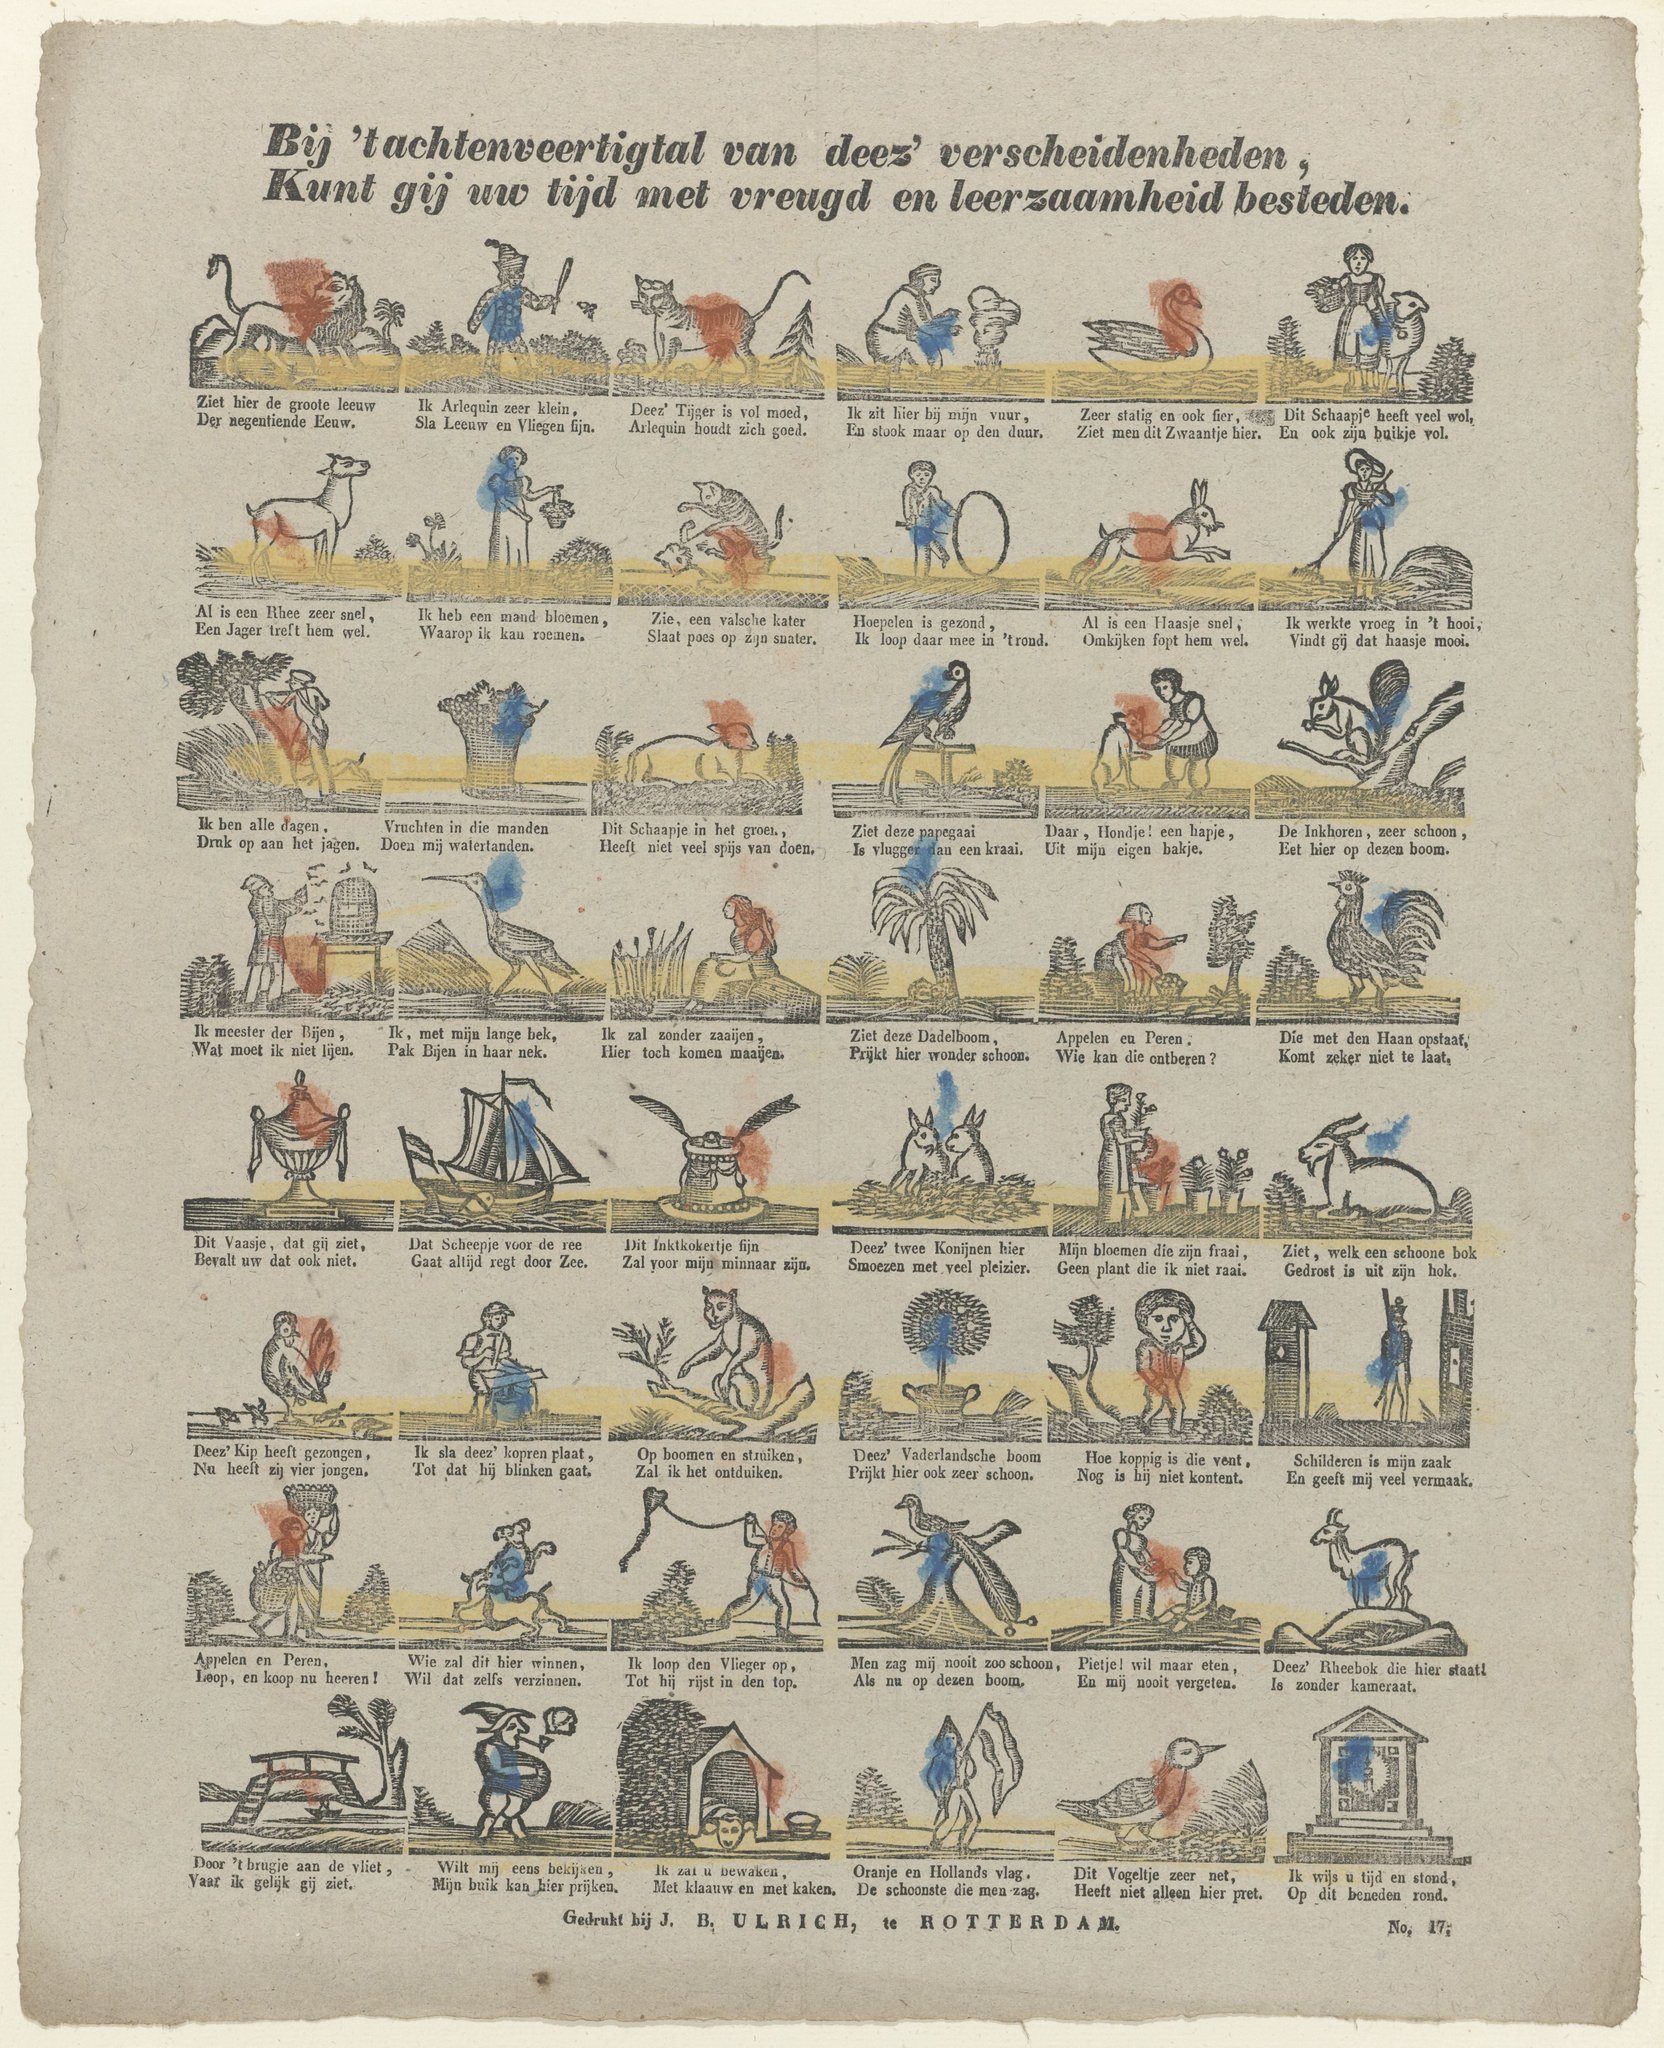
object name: print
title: Bij 't achtenveertigtal van deez' verscheidenheden, / Kunt gij uw tijd met vreugd en leerzaamheid besteden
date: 1816-1849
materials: paper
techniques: colour, letterpress printing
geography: netherlands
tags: animals, ships (in general), characters (human types), bridge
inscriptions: collector's mark: Lugt 2760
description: Blad met 48 voorstellingen van dieren, figuren en voorwerpen, waaronder een leeuw, een jongen met een hoepel, een schip en een brug. Onder elke voorstelling een tweeregelig vers. Genummerd rechtsonder: No. 17.